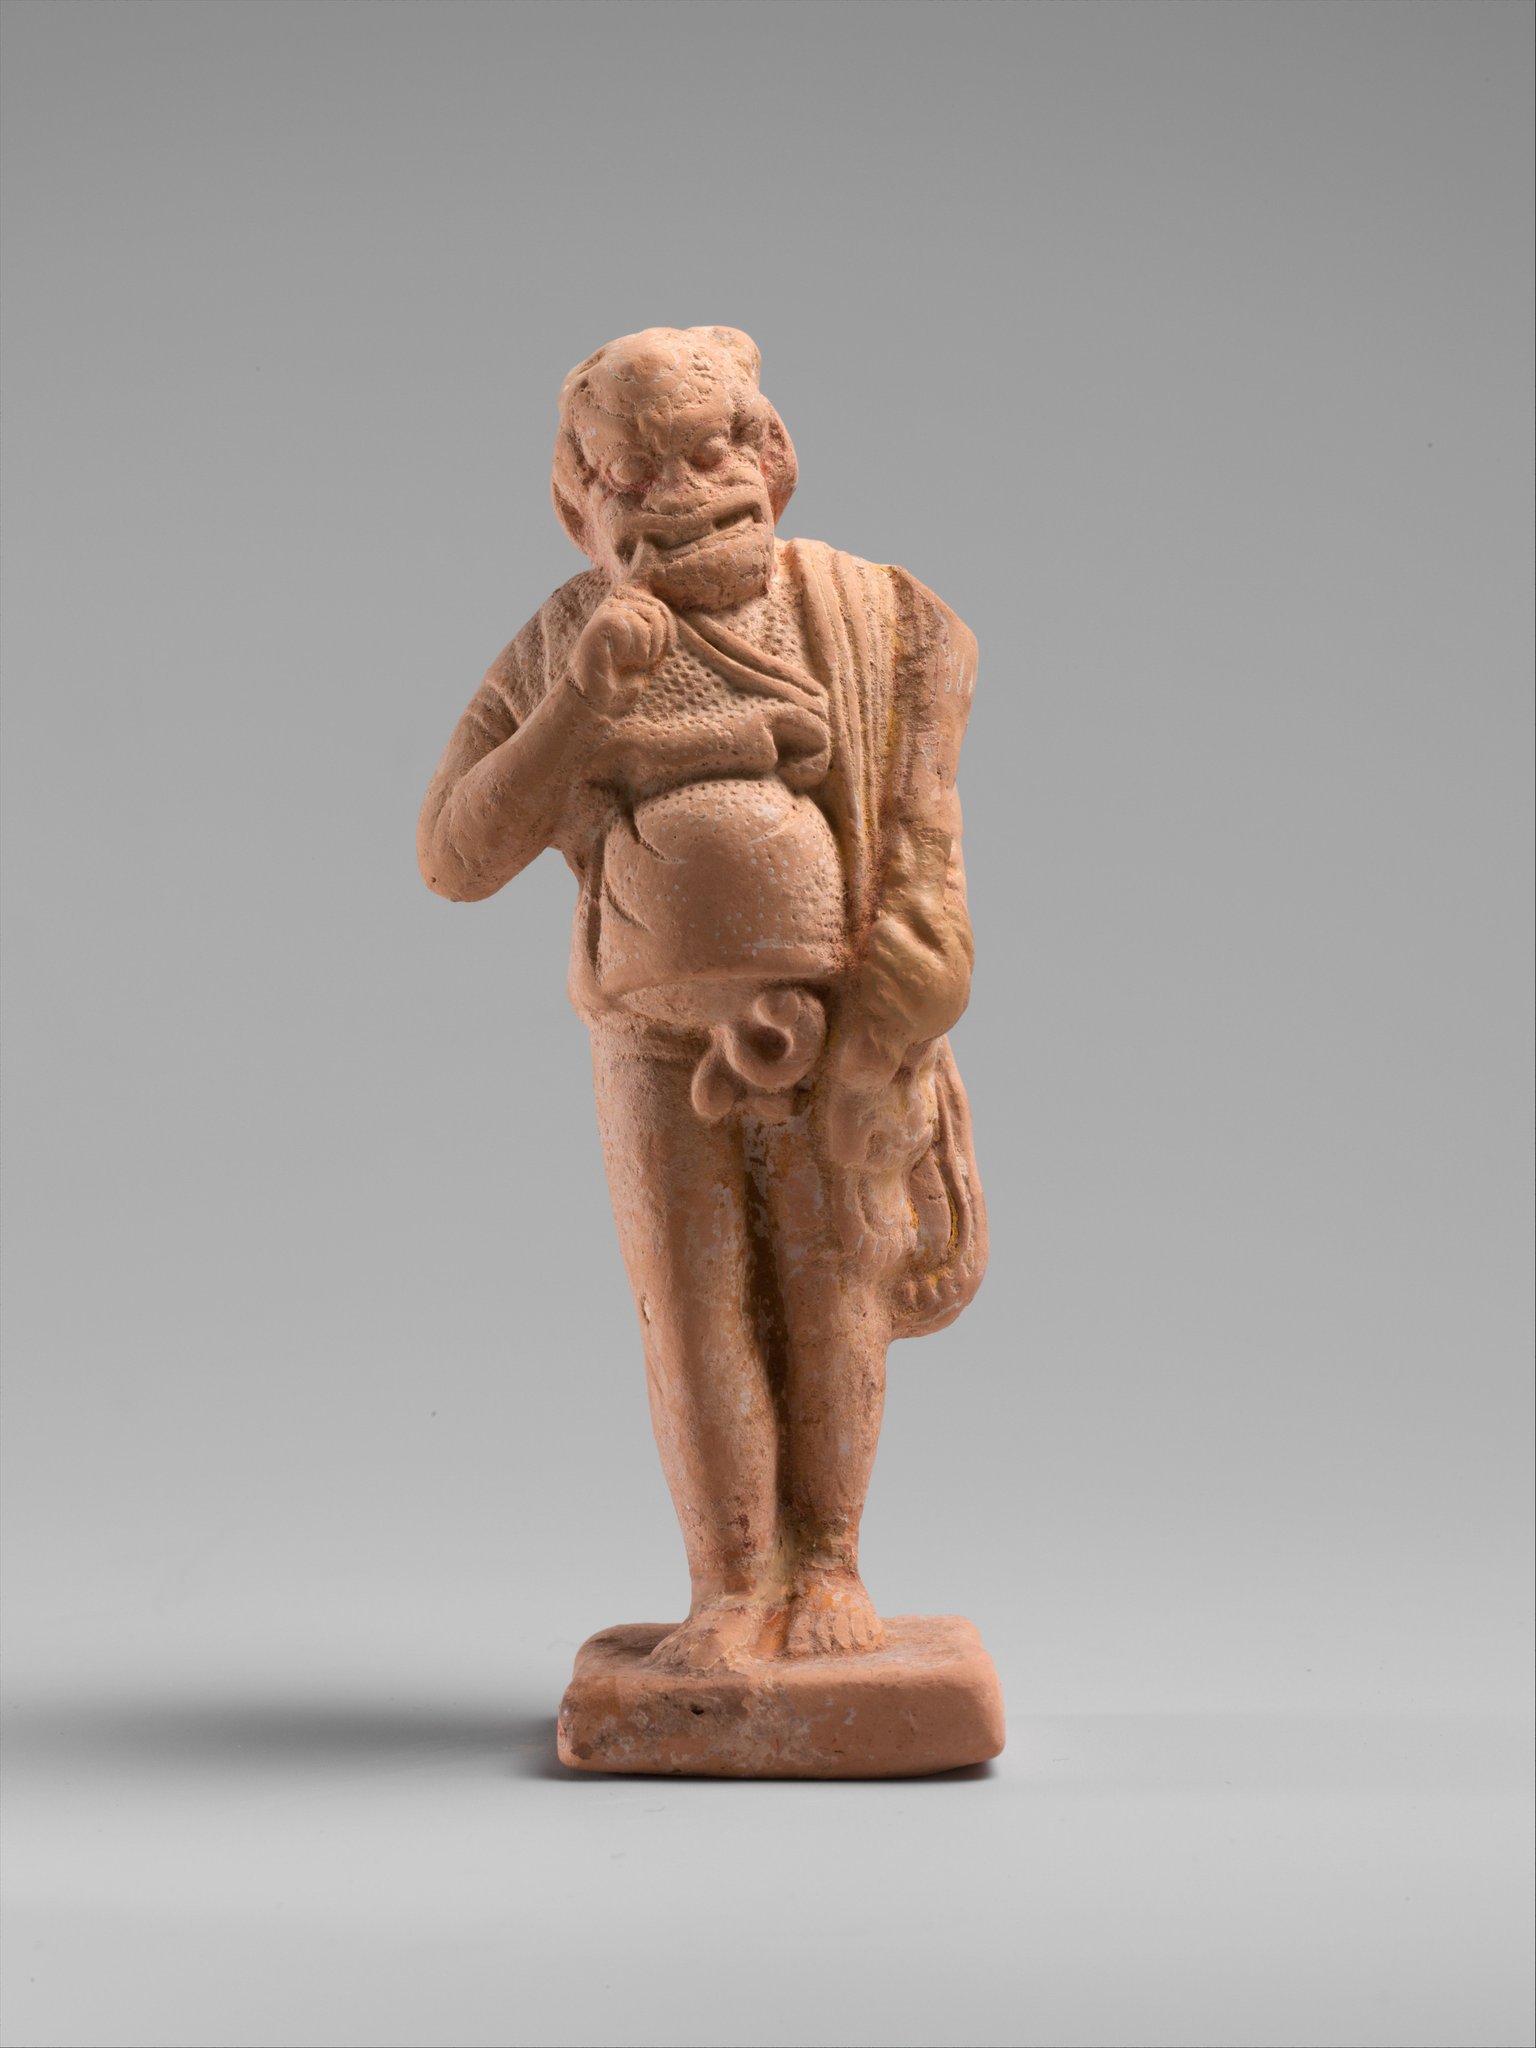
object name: statuette of an actor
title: Terracotta statuette of an actor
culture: greek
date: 434-368 BCE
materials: terracotta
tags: men,actors